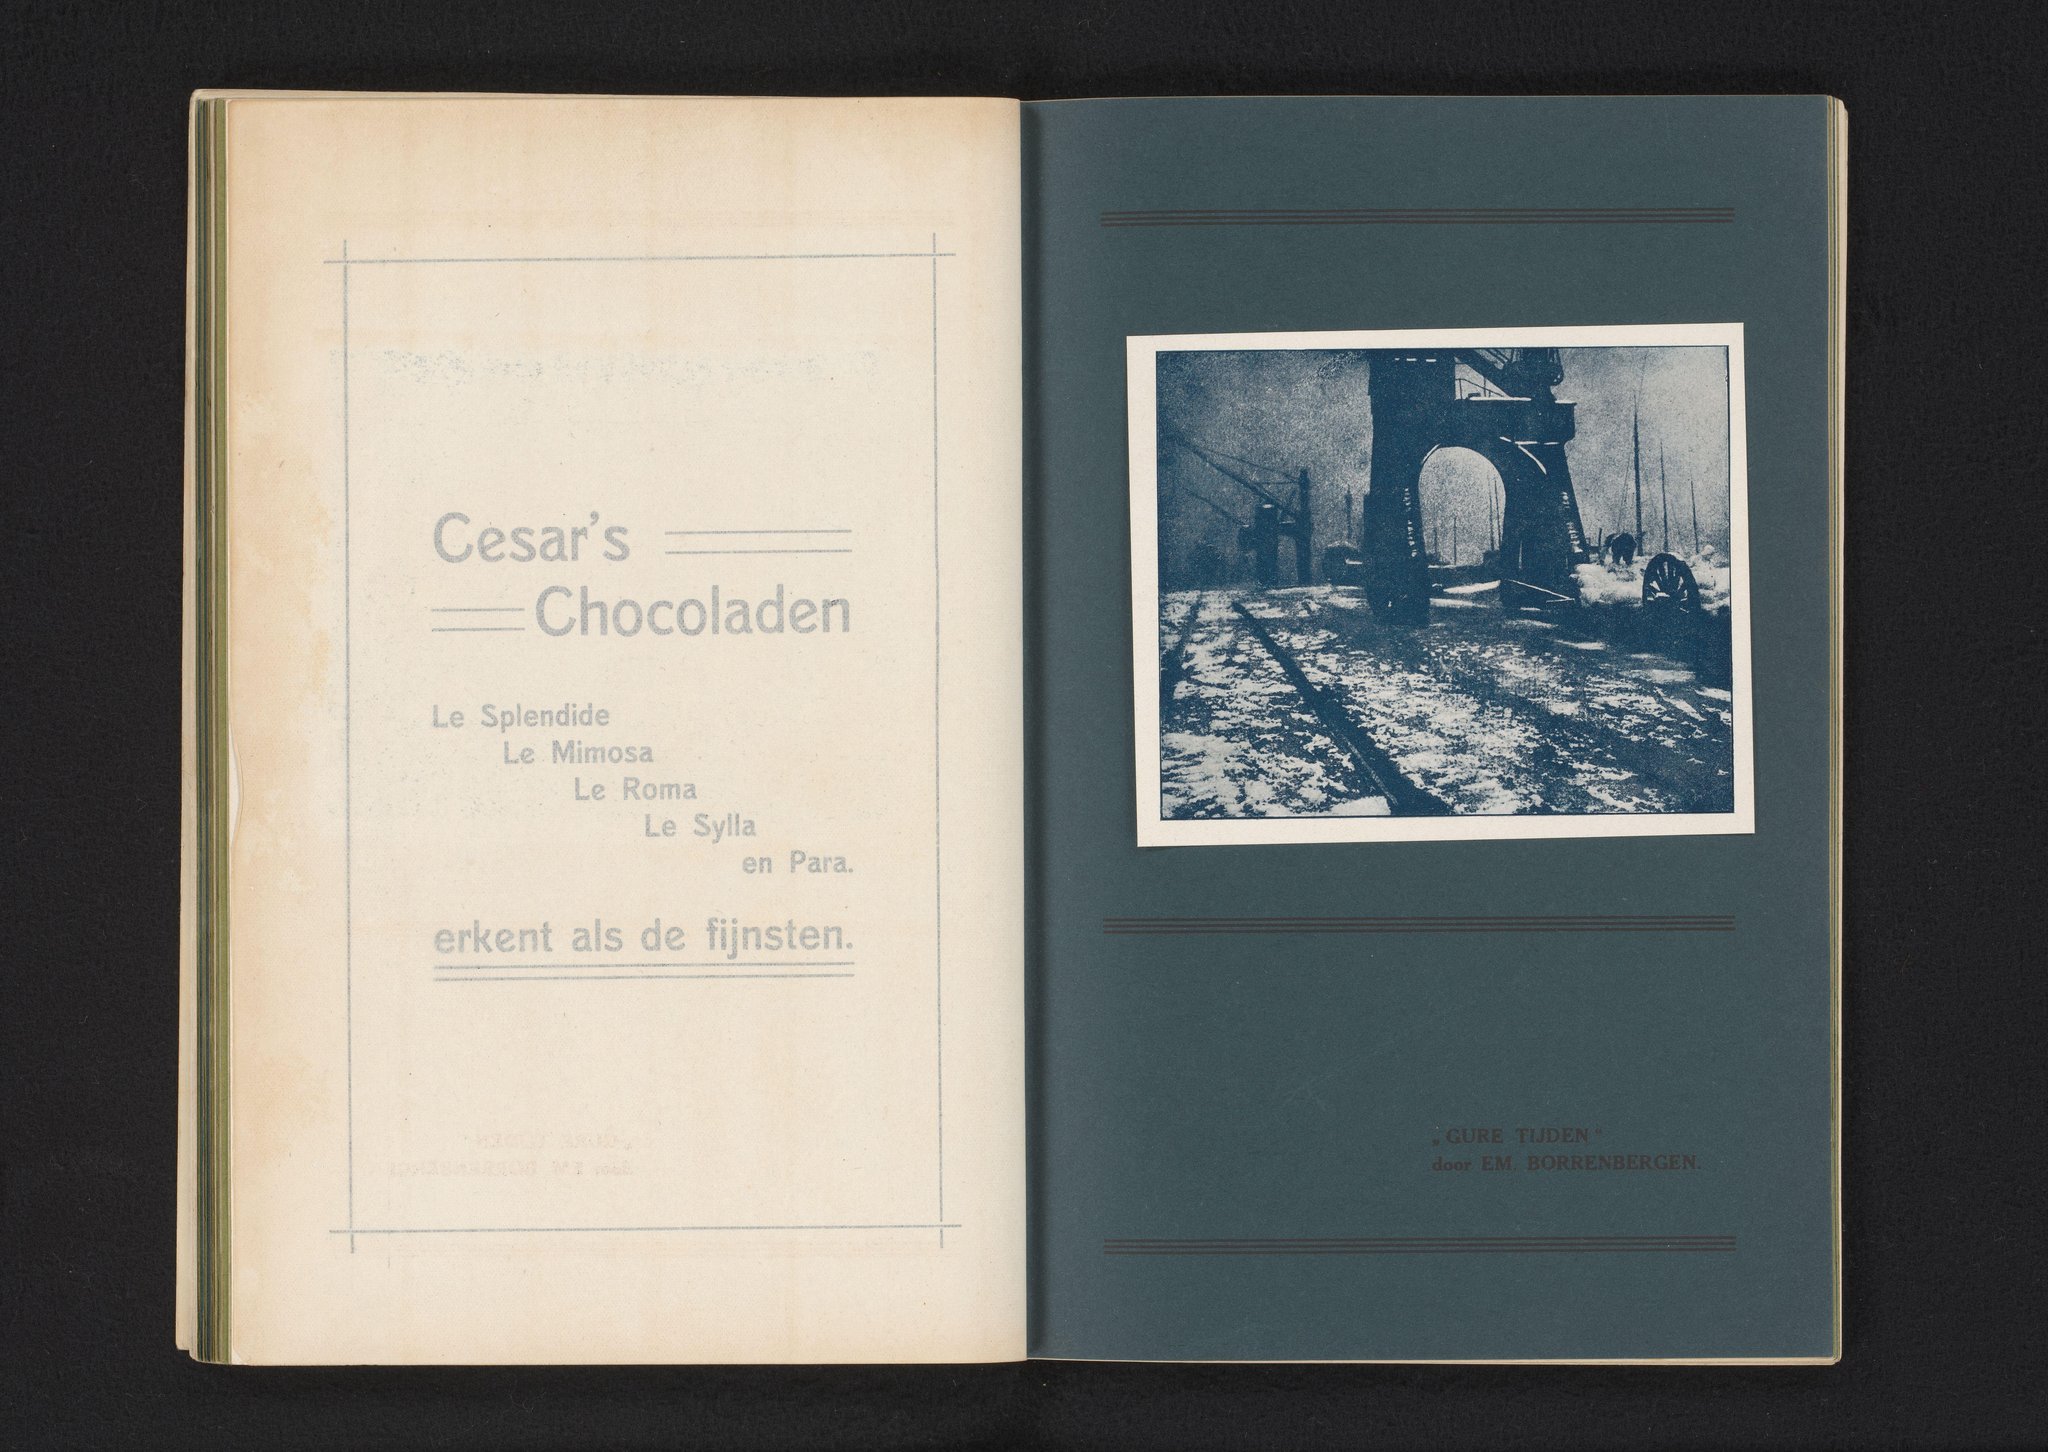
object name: photomechanical print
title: Besneeuwd industriegebied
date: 1911-1916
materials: paper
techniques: autotype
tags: snow, industries